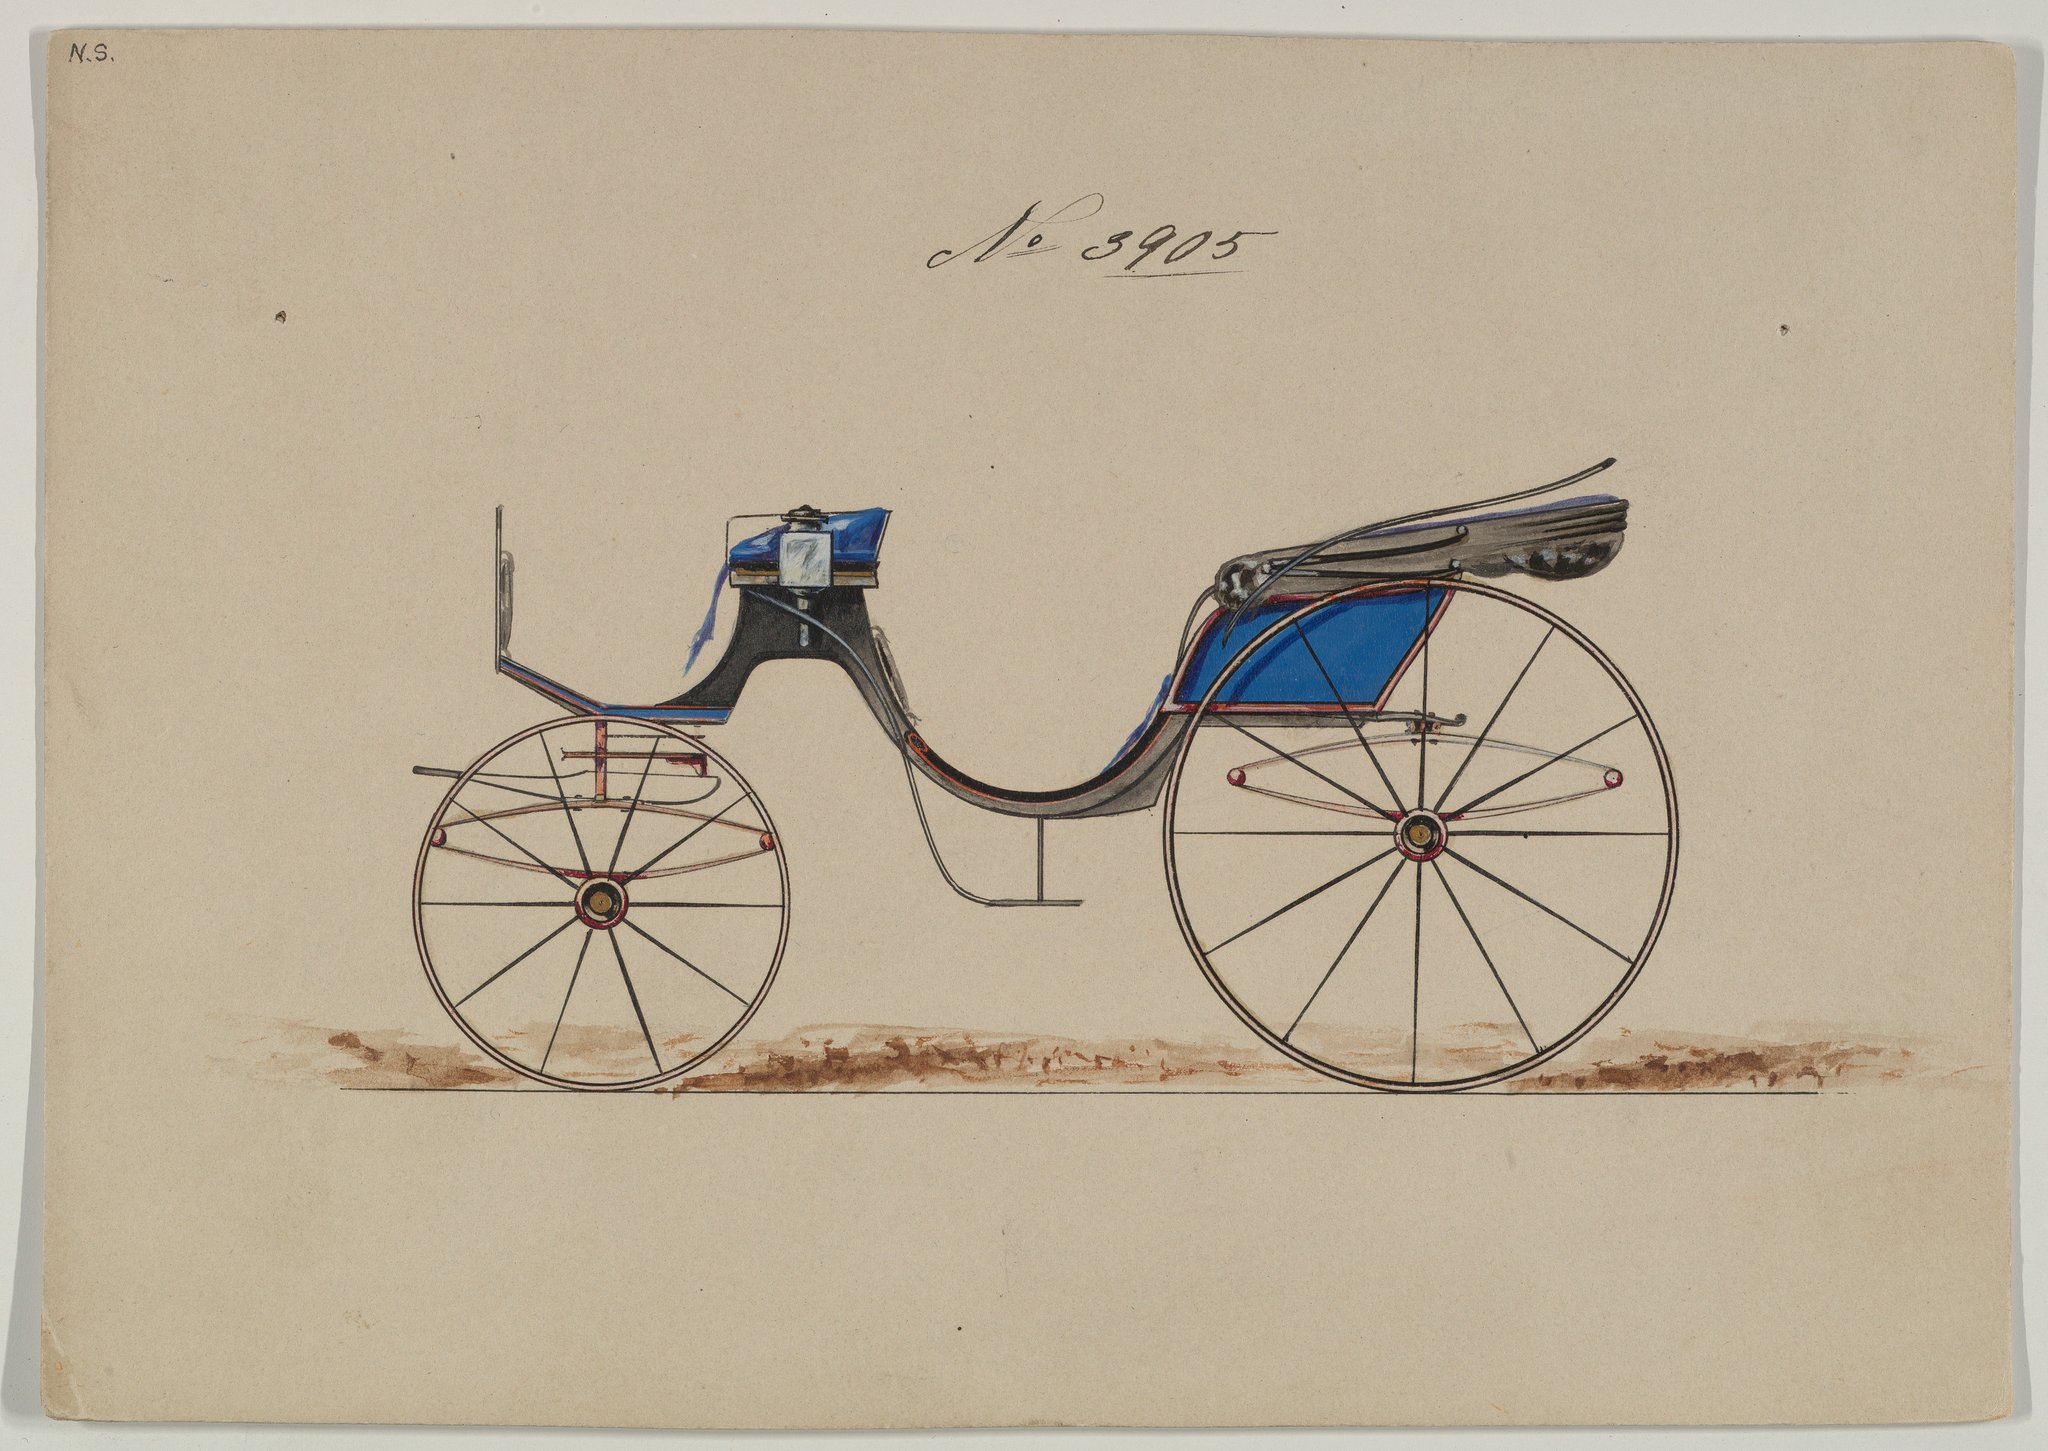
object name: drawing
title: Design for Cabriolet or Victoria, no. 3905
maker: brewster & co.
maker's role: manufacturer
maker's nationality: american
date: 1884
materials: gouache, gum arabic, ink, watercolor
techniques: pen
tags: carriages